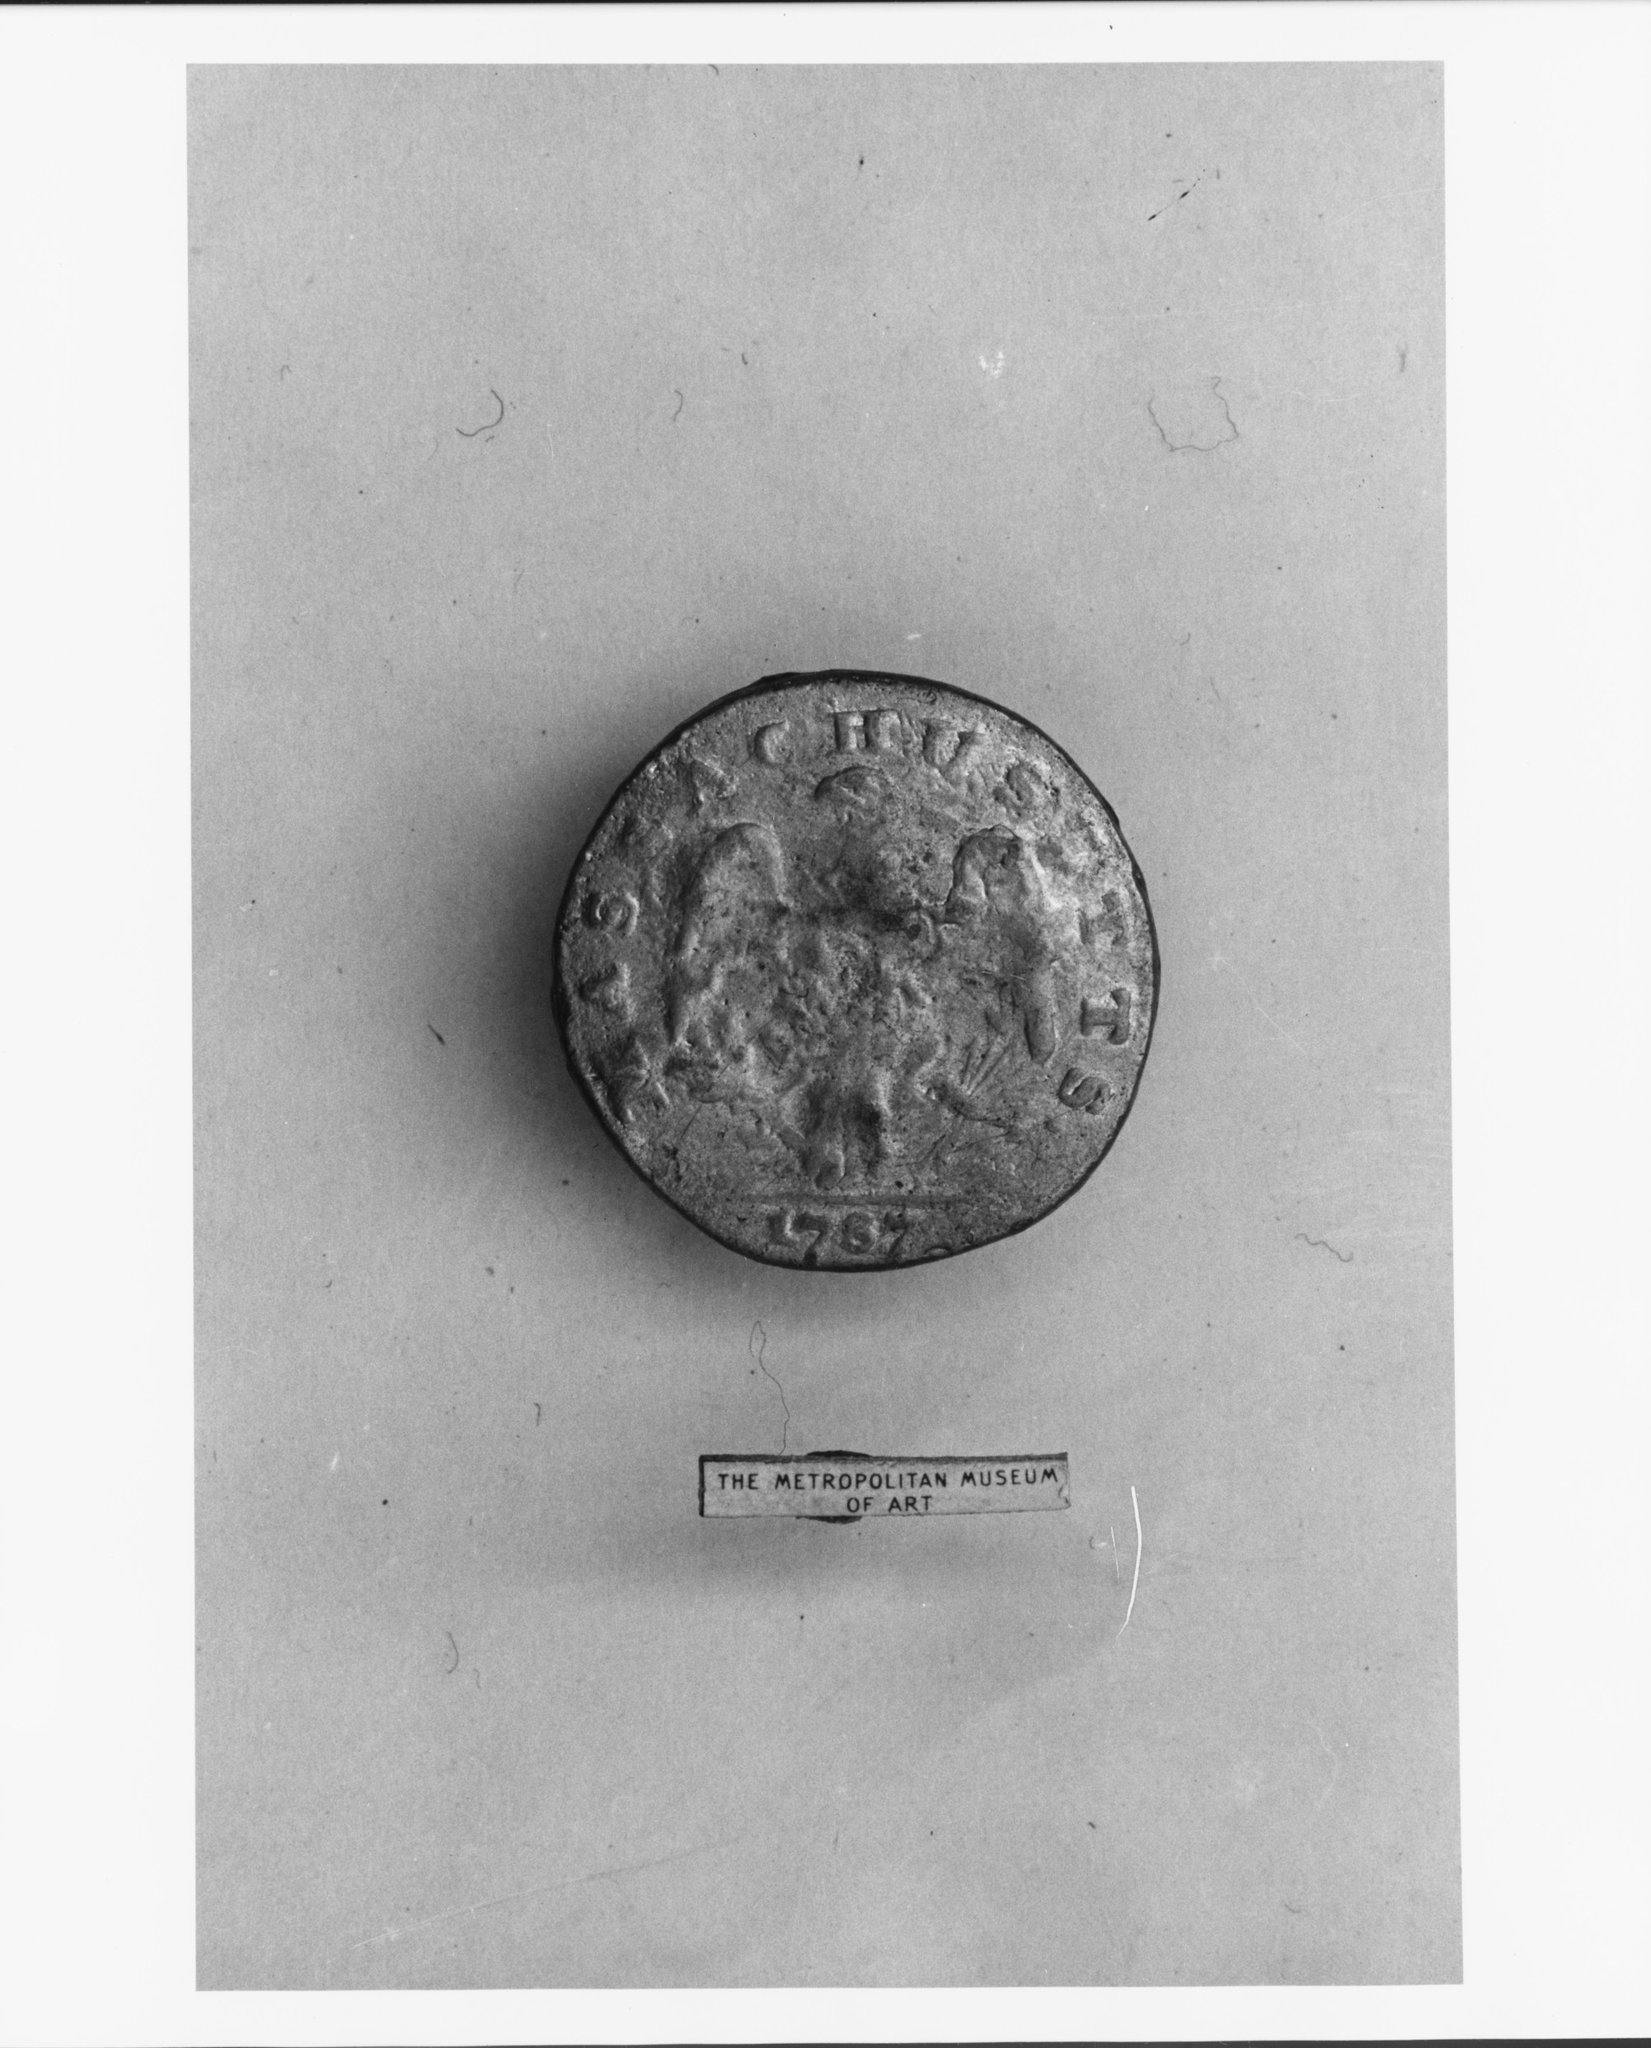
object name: button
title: Button from a Uniform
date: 1770-1800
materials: pewter